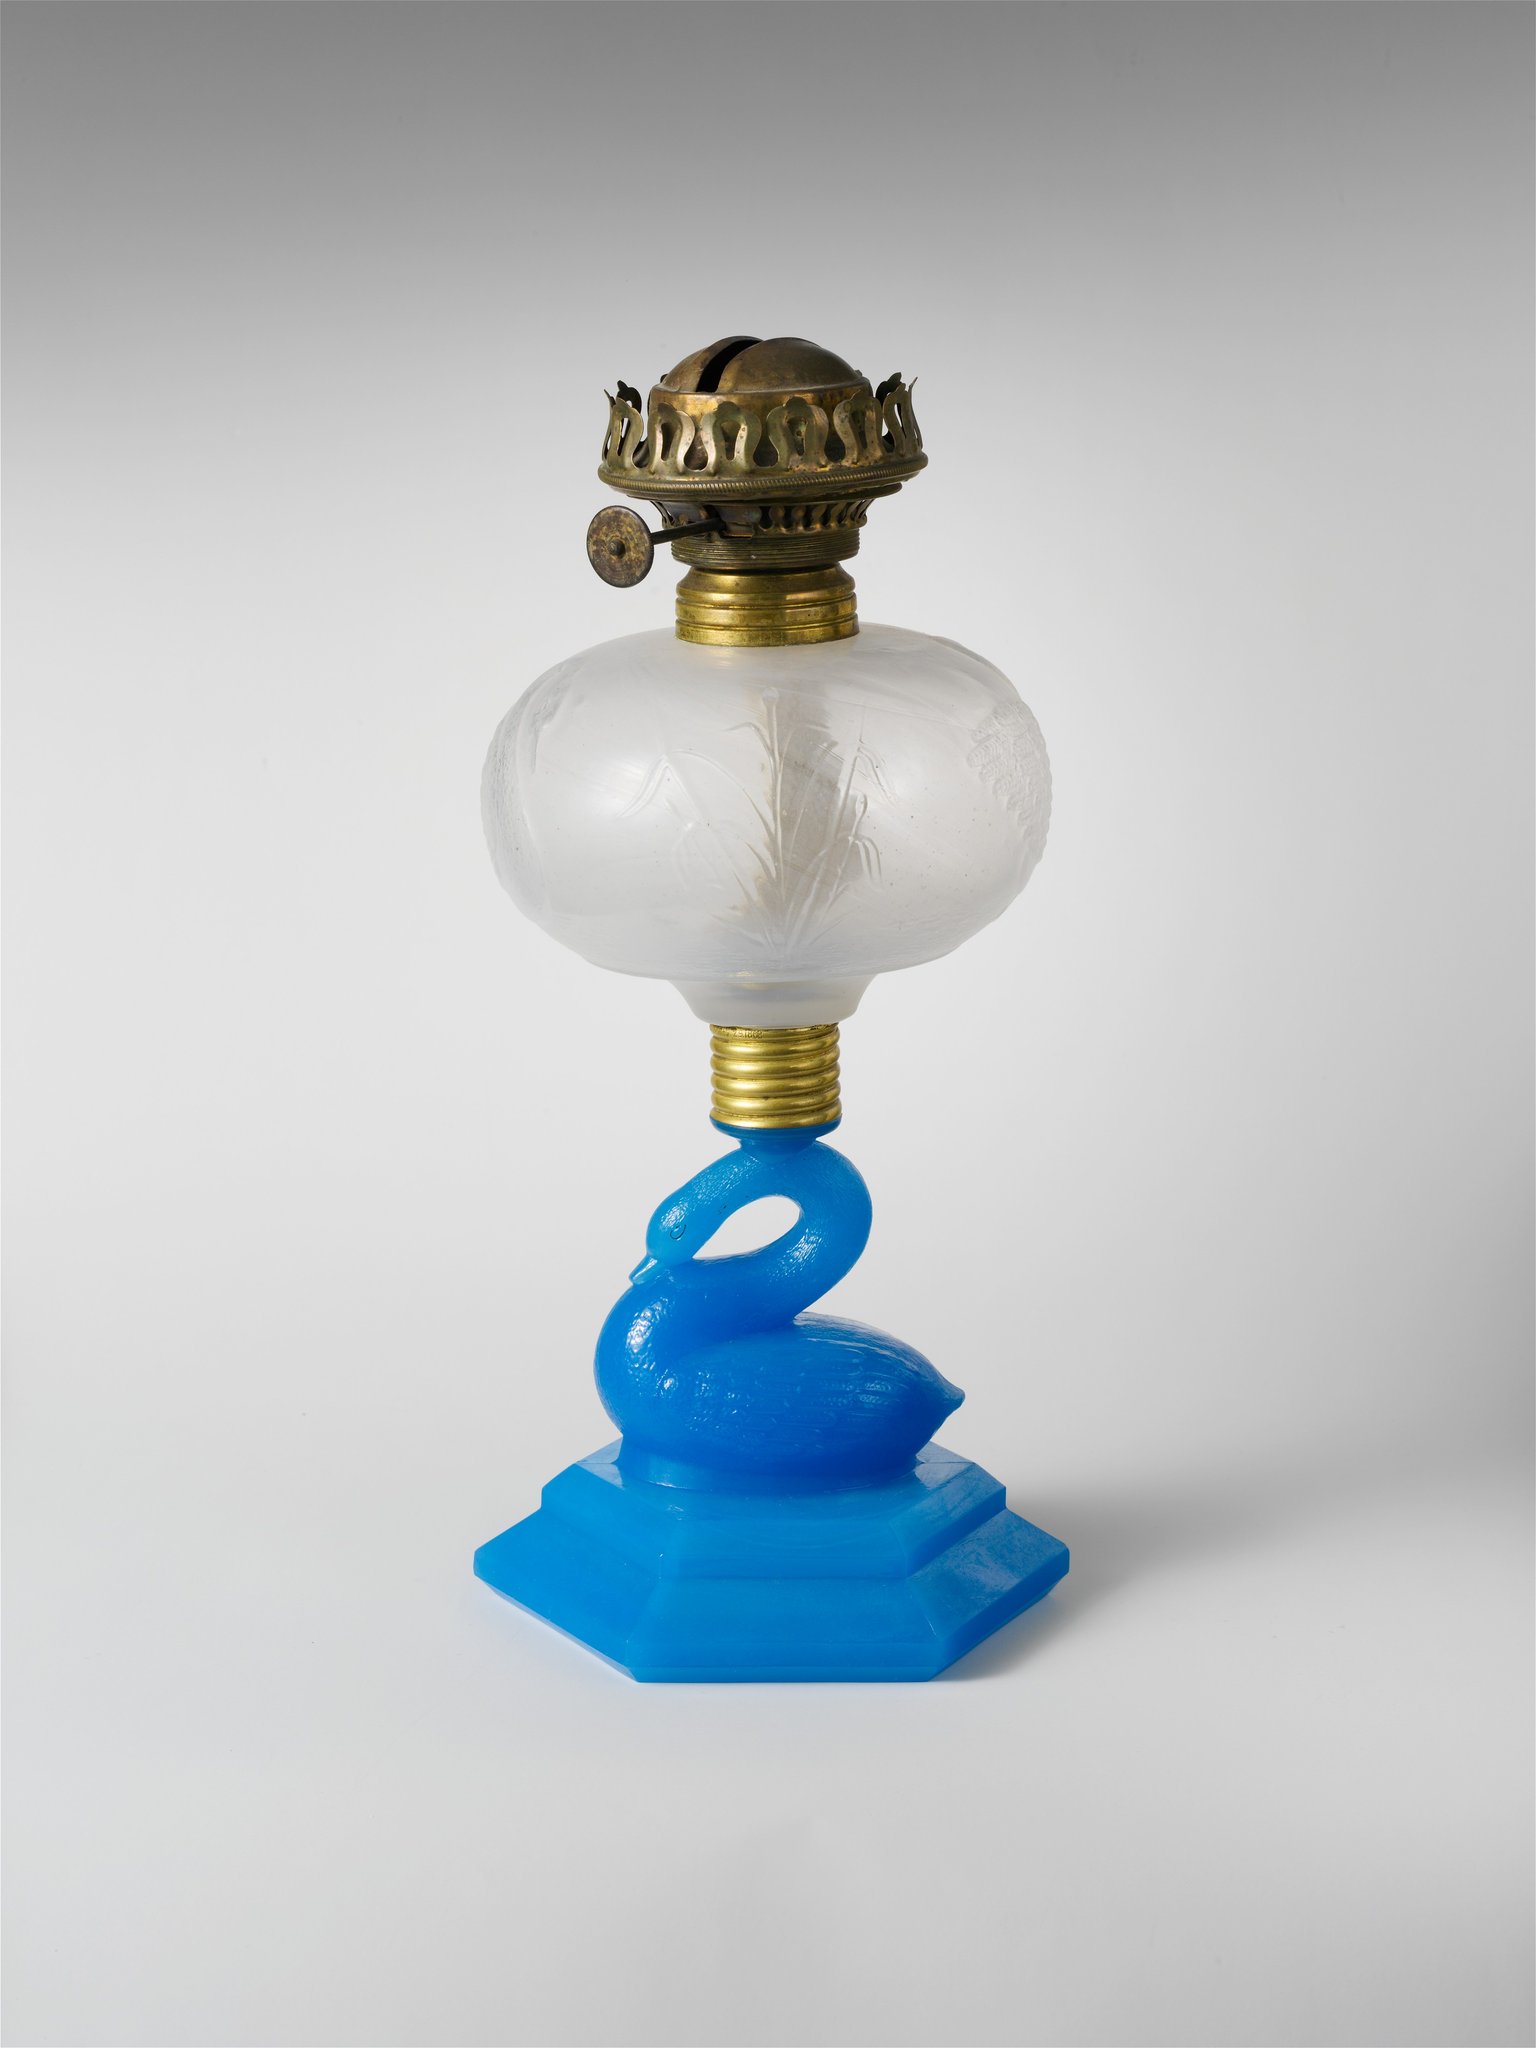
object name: lamp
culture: american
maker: atterbury and company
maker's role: maker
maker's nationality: american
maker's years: 1864-1893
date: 1868-1875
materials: brass, glass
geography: united states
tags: swans